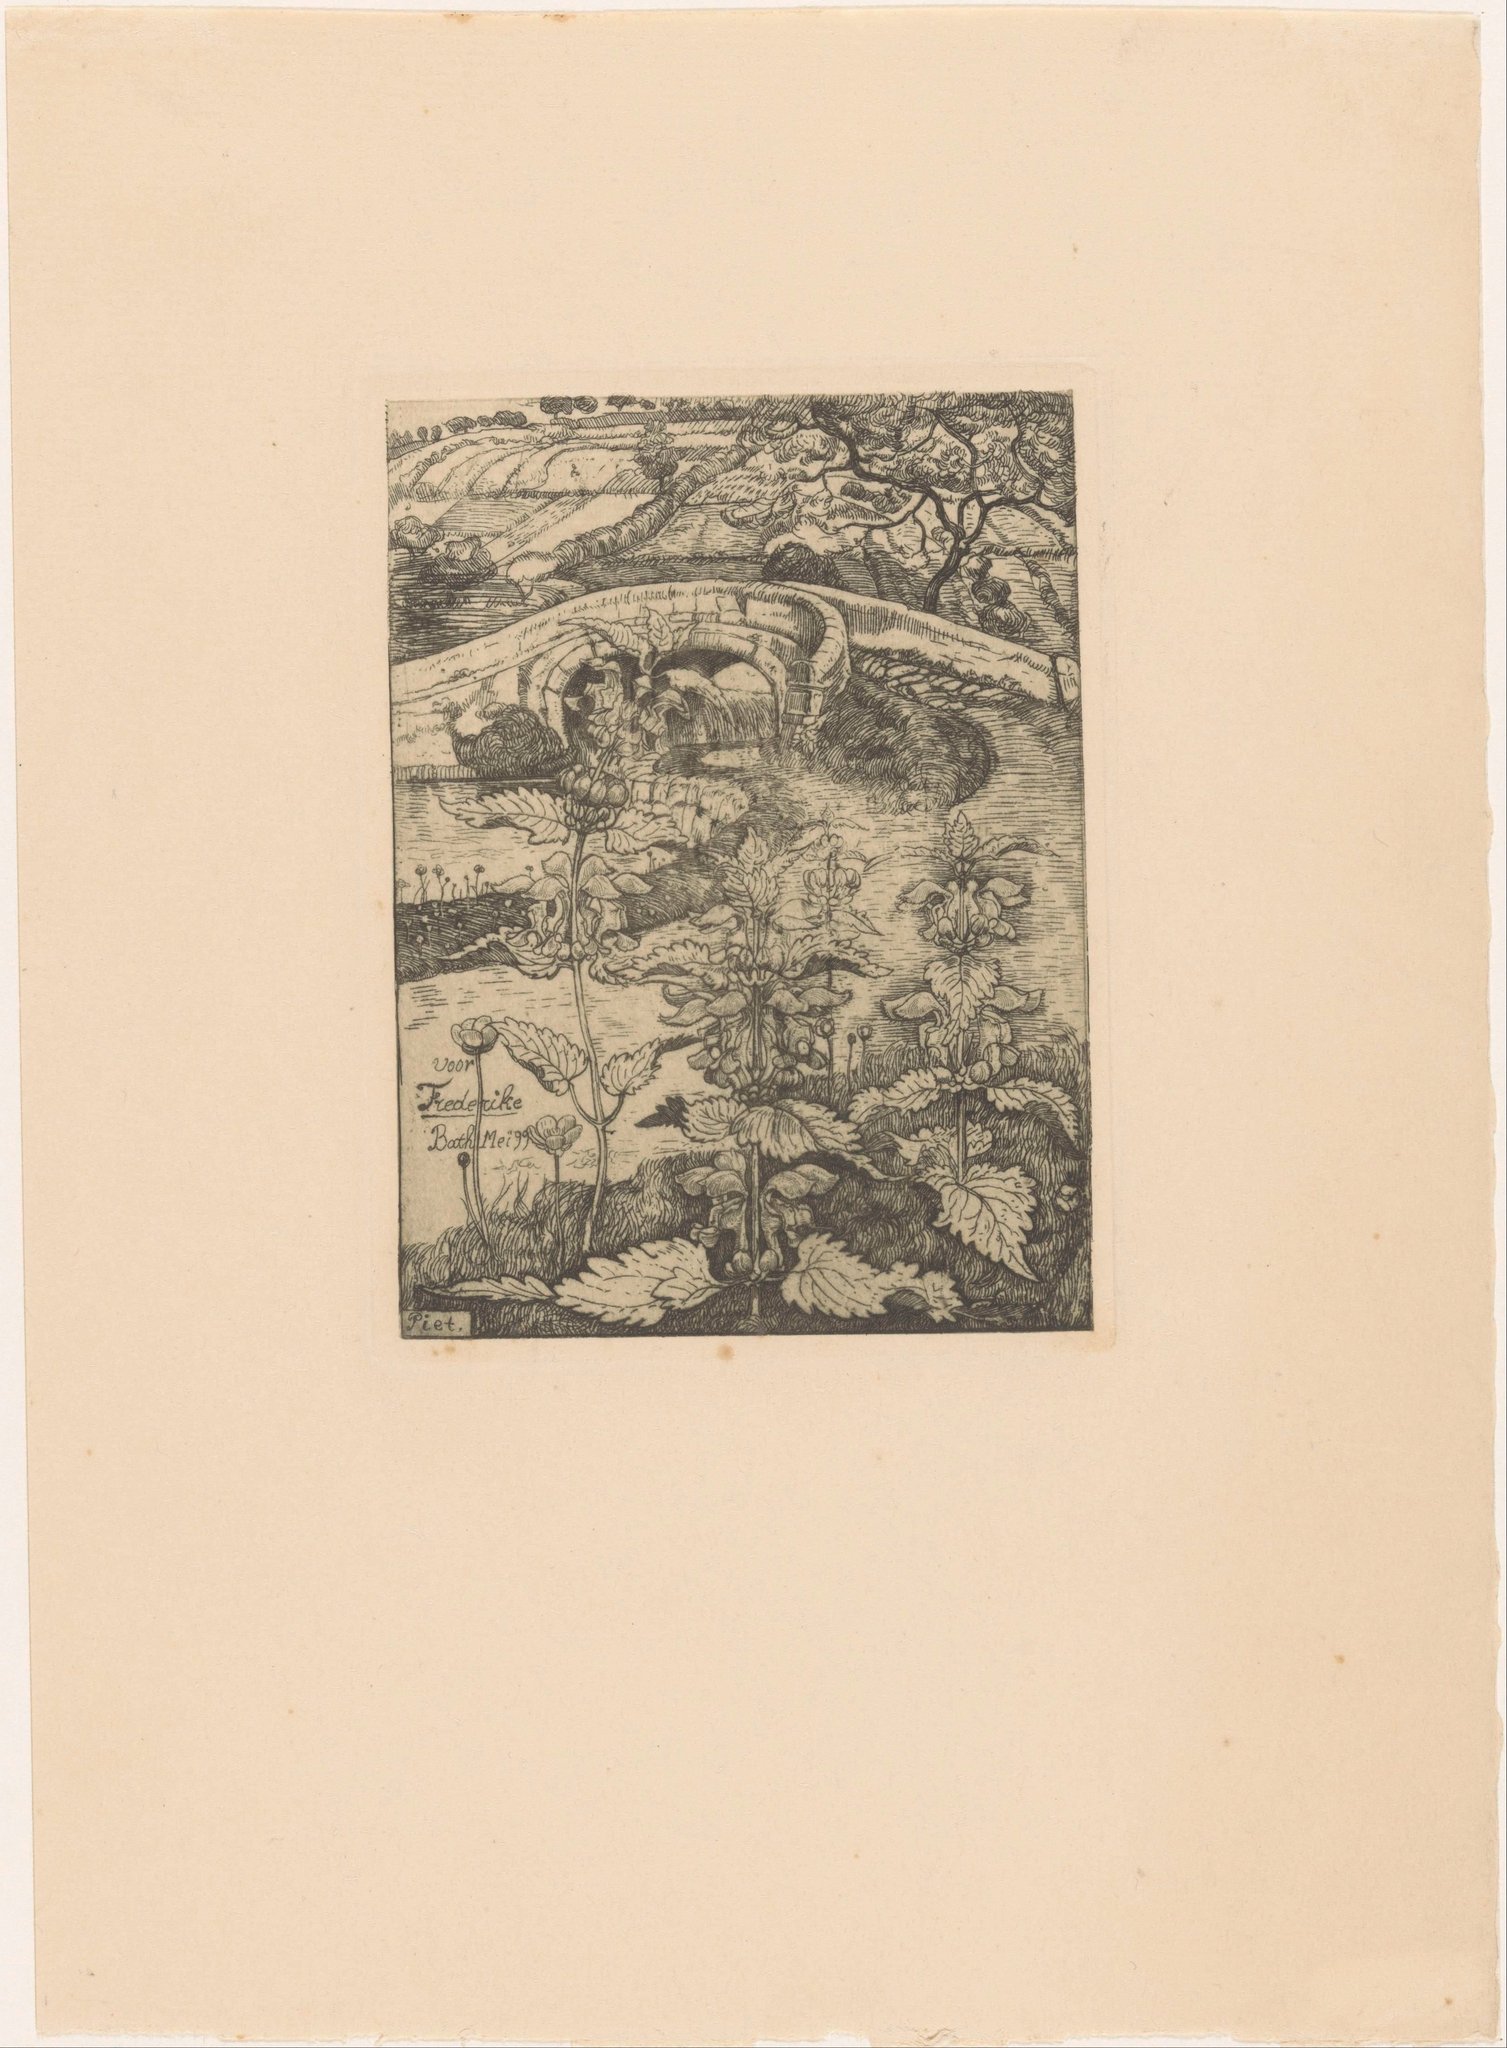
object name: print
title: Heuvellandschap met brug in Bath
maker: pieter dupont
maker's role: draughtsman, print maker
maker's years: 1870-1911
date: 1805-1899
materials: paper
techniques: etching, intaglio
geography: paris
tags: low hill country, plants and herbs: nettle, bridge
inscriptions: collector's mark: ‘v.D’, collector's mark: Lugt 2228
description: Op de voorgrond dovenetels. Linksonder de tekst 'voor Frederike', een verwijzing naar de verloofde van Pieter Dupont, Frederike Vaarzon Morel.